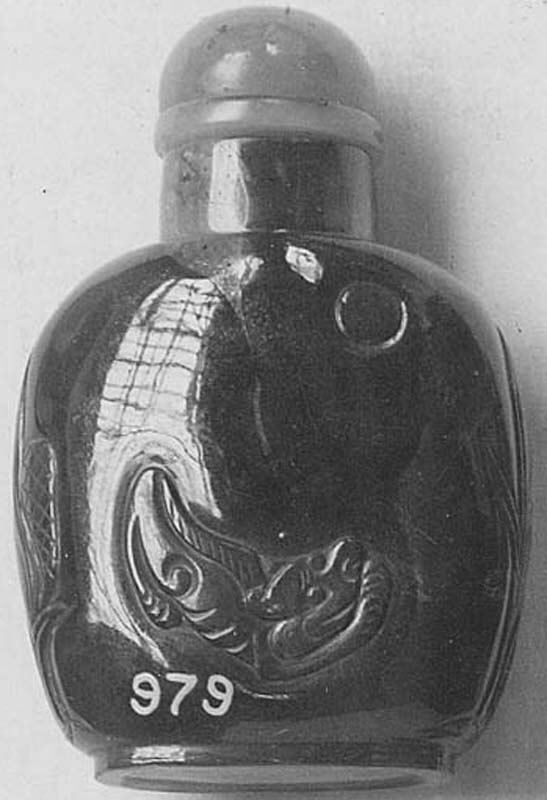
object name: snuff bottle with stopper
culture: chinese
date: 1701-1900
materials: stone, quartz